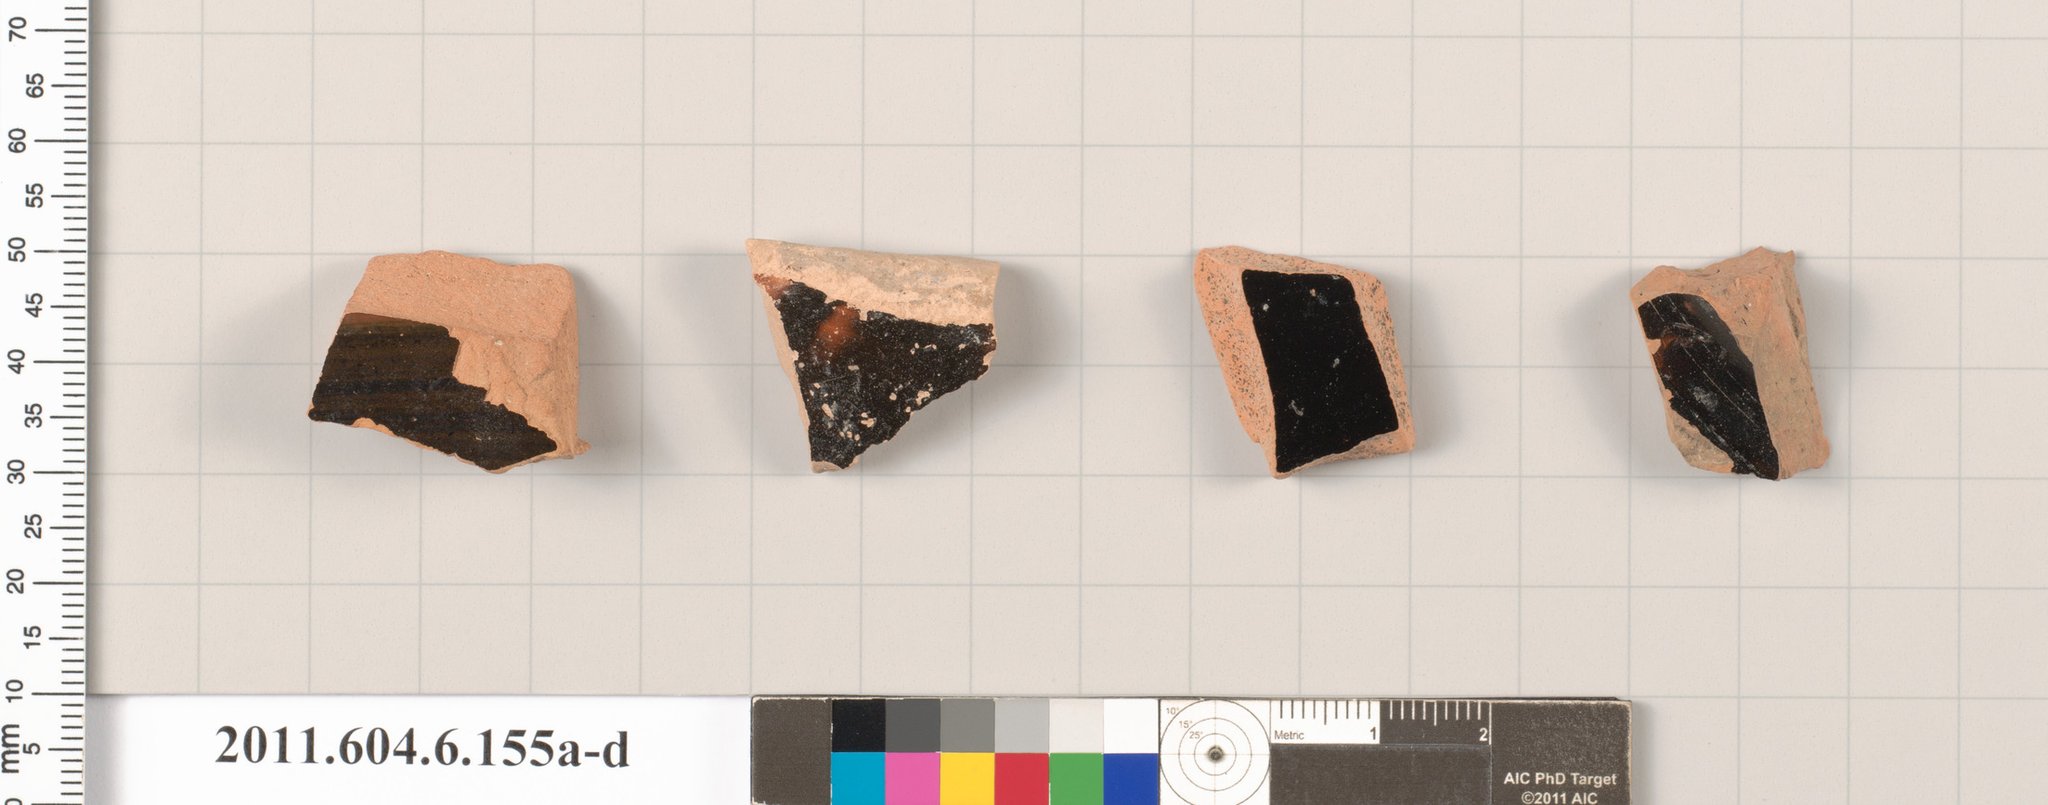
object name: undetermined open shape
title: Terracotta fragments of open shapes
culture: greek, attic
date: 600-401 BCE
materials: terracotta